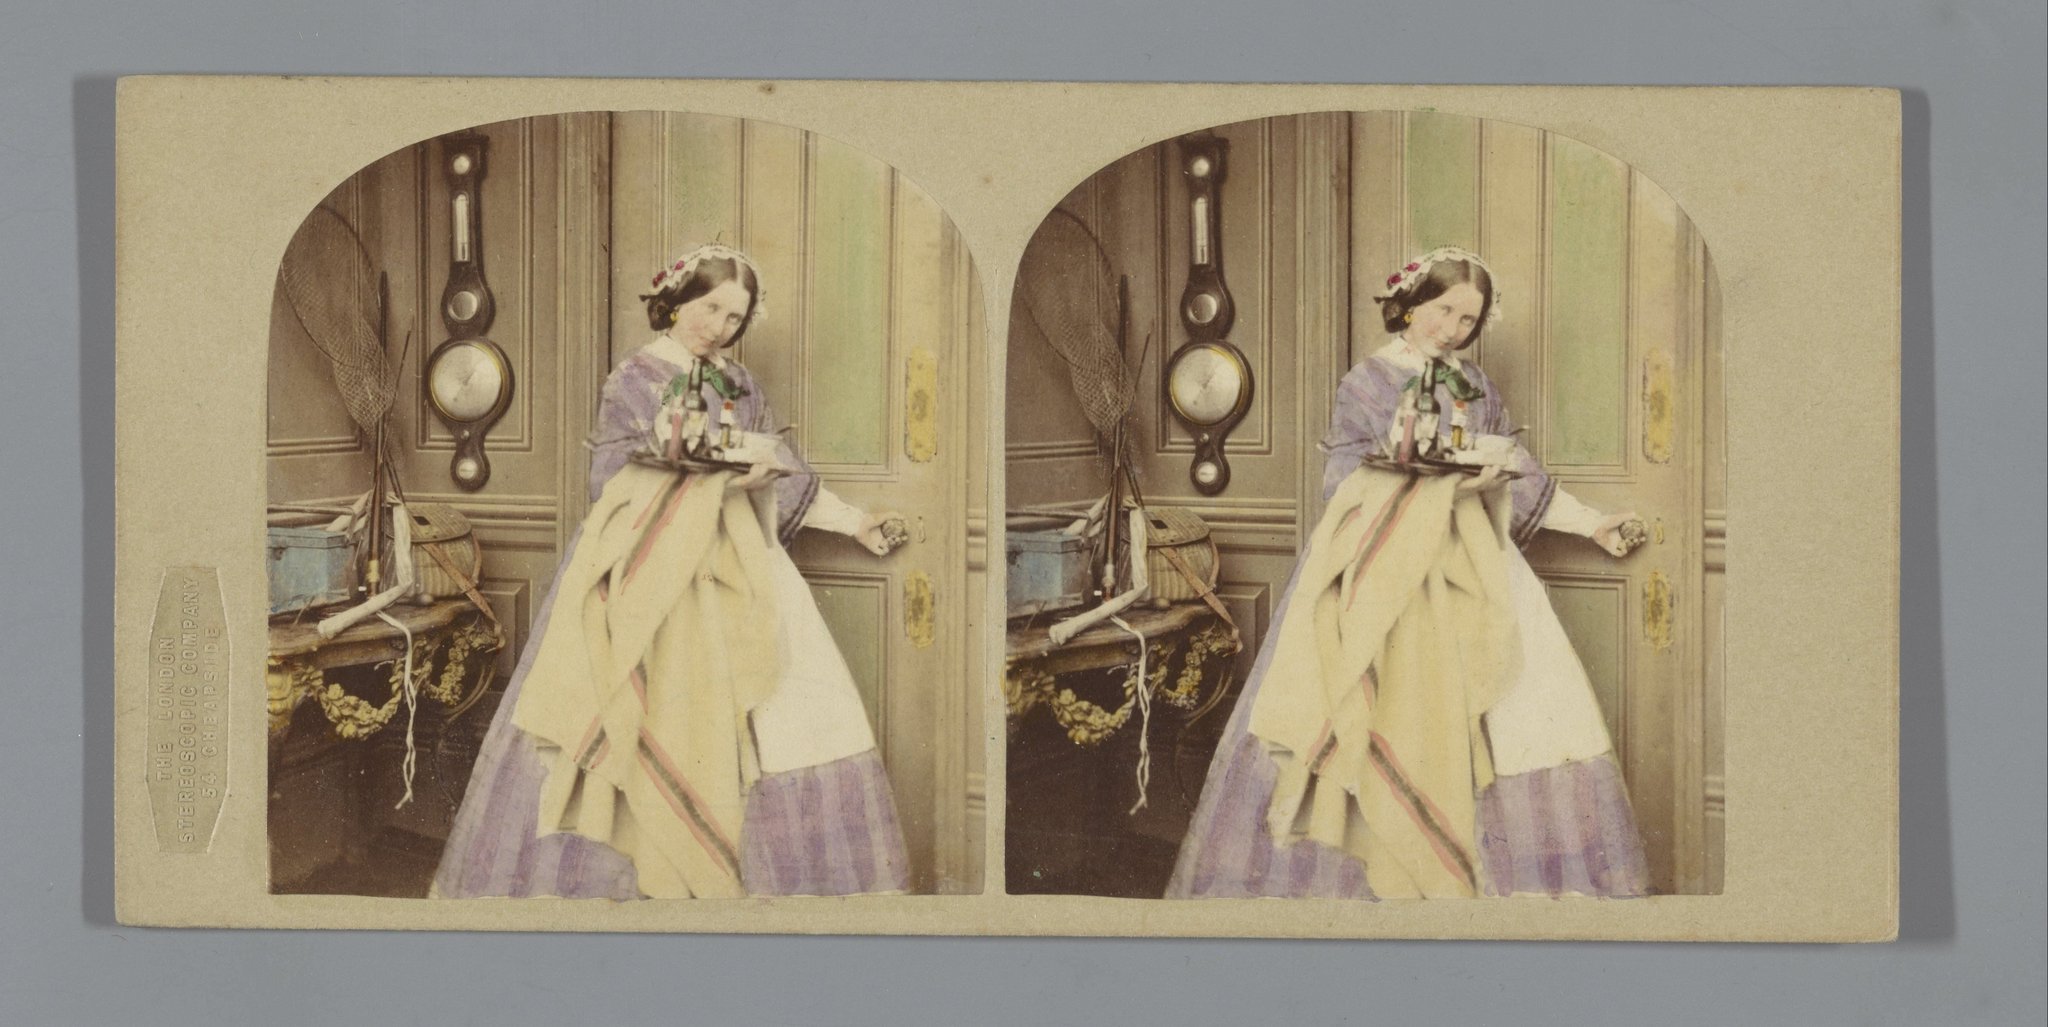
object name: stereograph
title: Good for a Cold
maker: Anonymous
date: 1856-1859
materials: cardboard, paper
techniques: albumen print, hand coloring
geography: london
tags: nursing, tending the sick